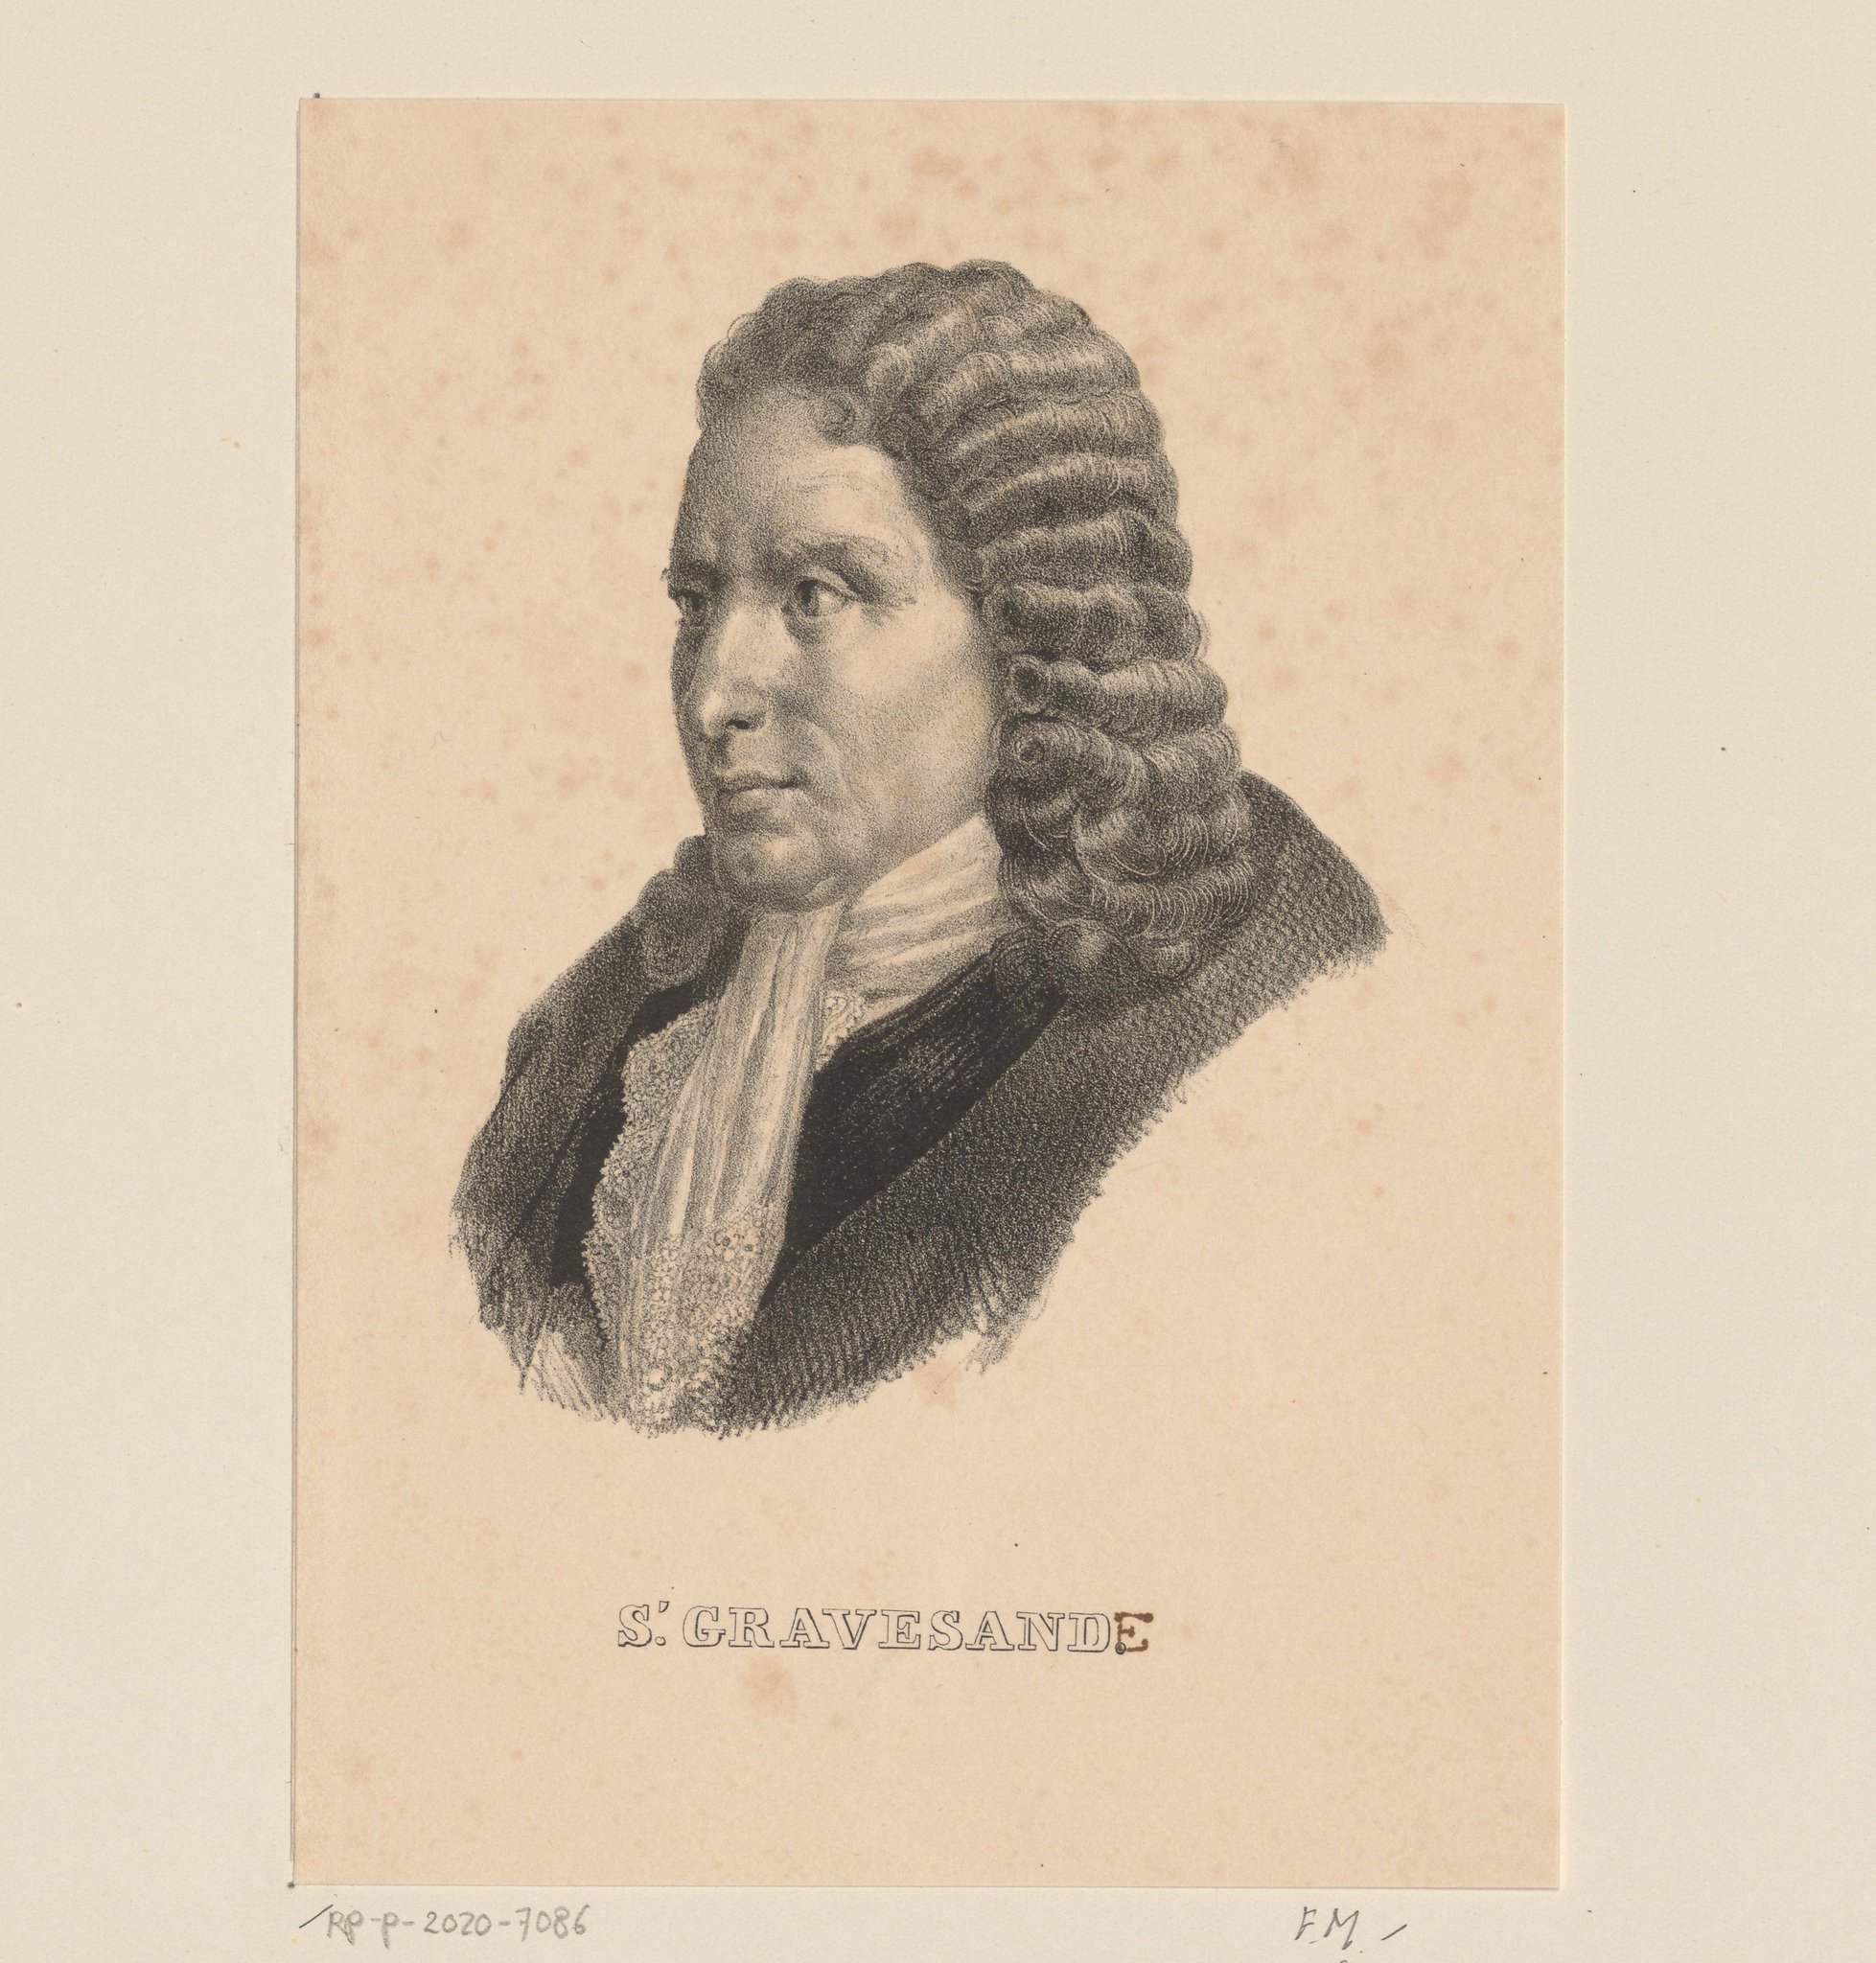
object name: print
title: Portret van Cornelius 's-Gravesande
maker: Anonymous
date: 1700-1800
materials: paper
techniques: lithograph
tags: delft, historical persons